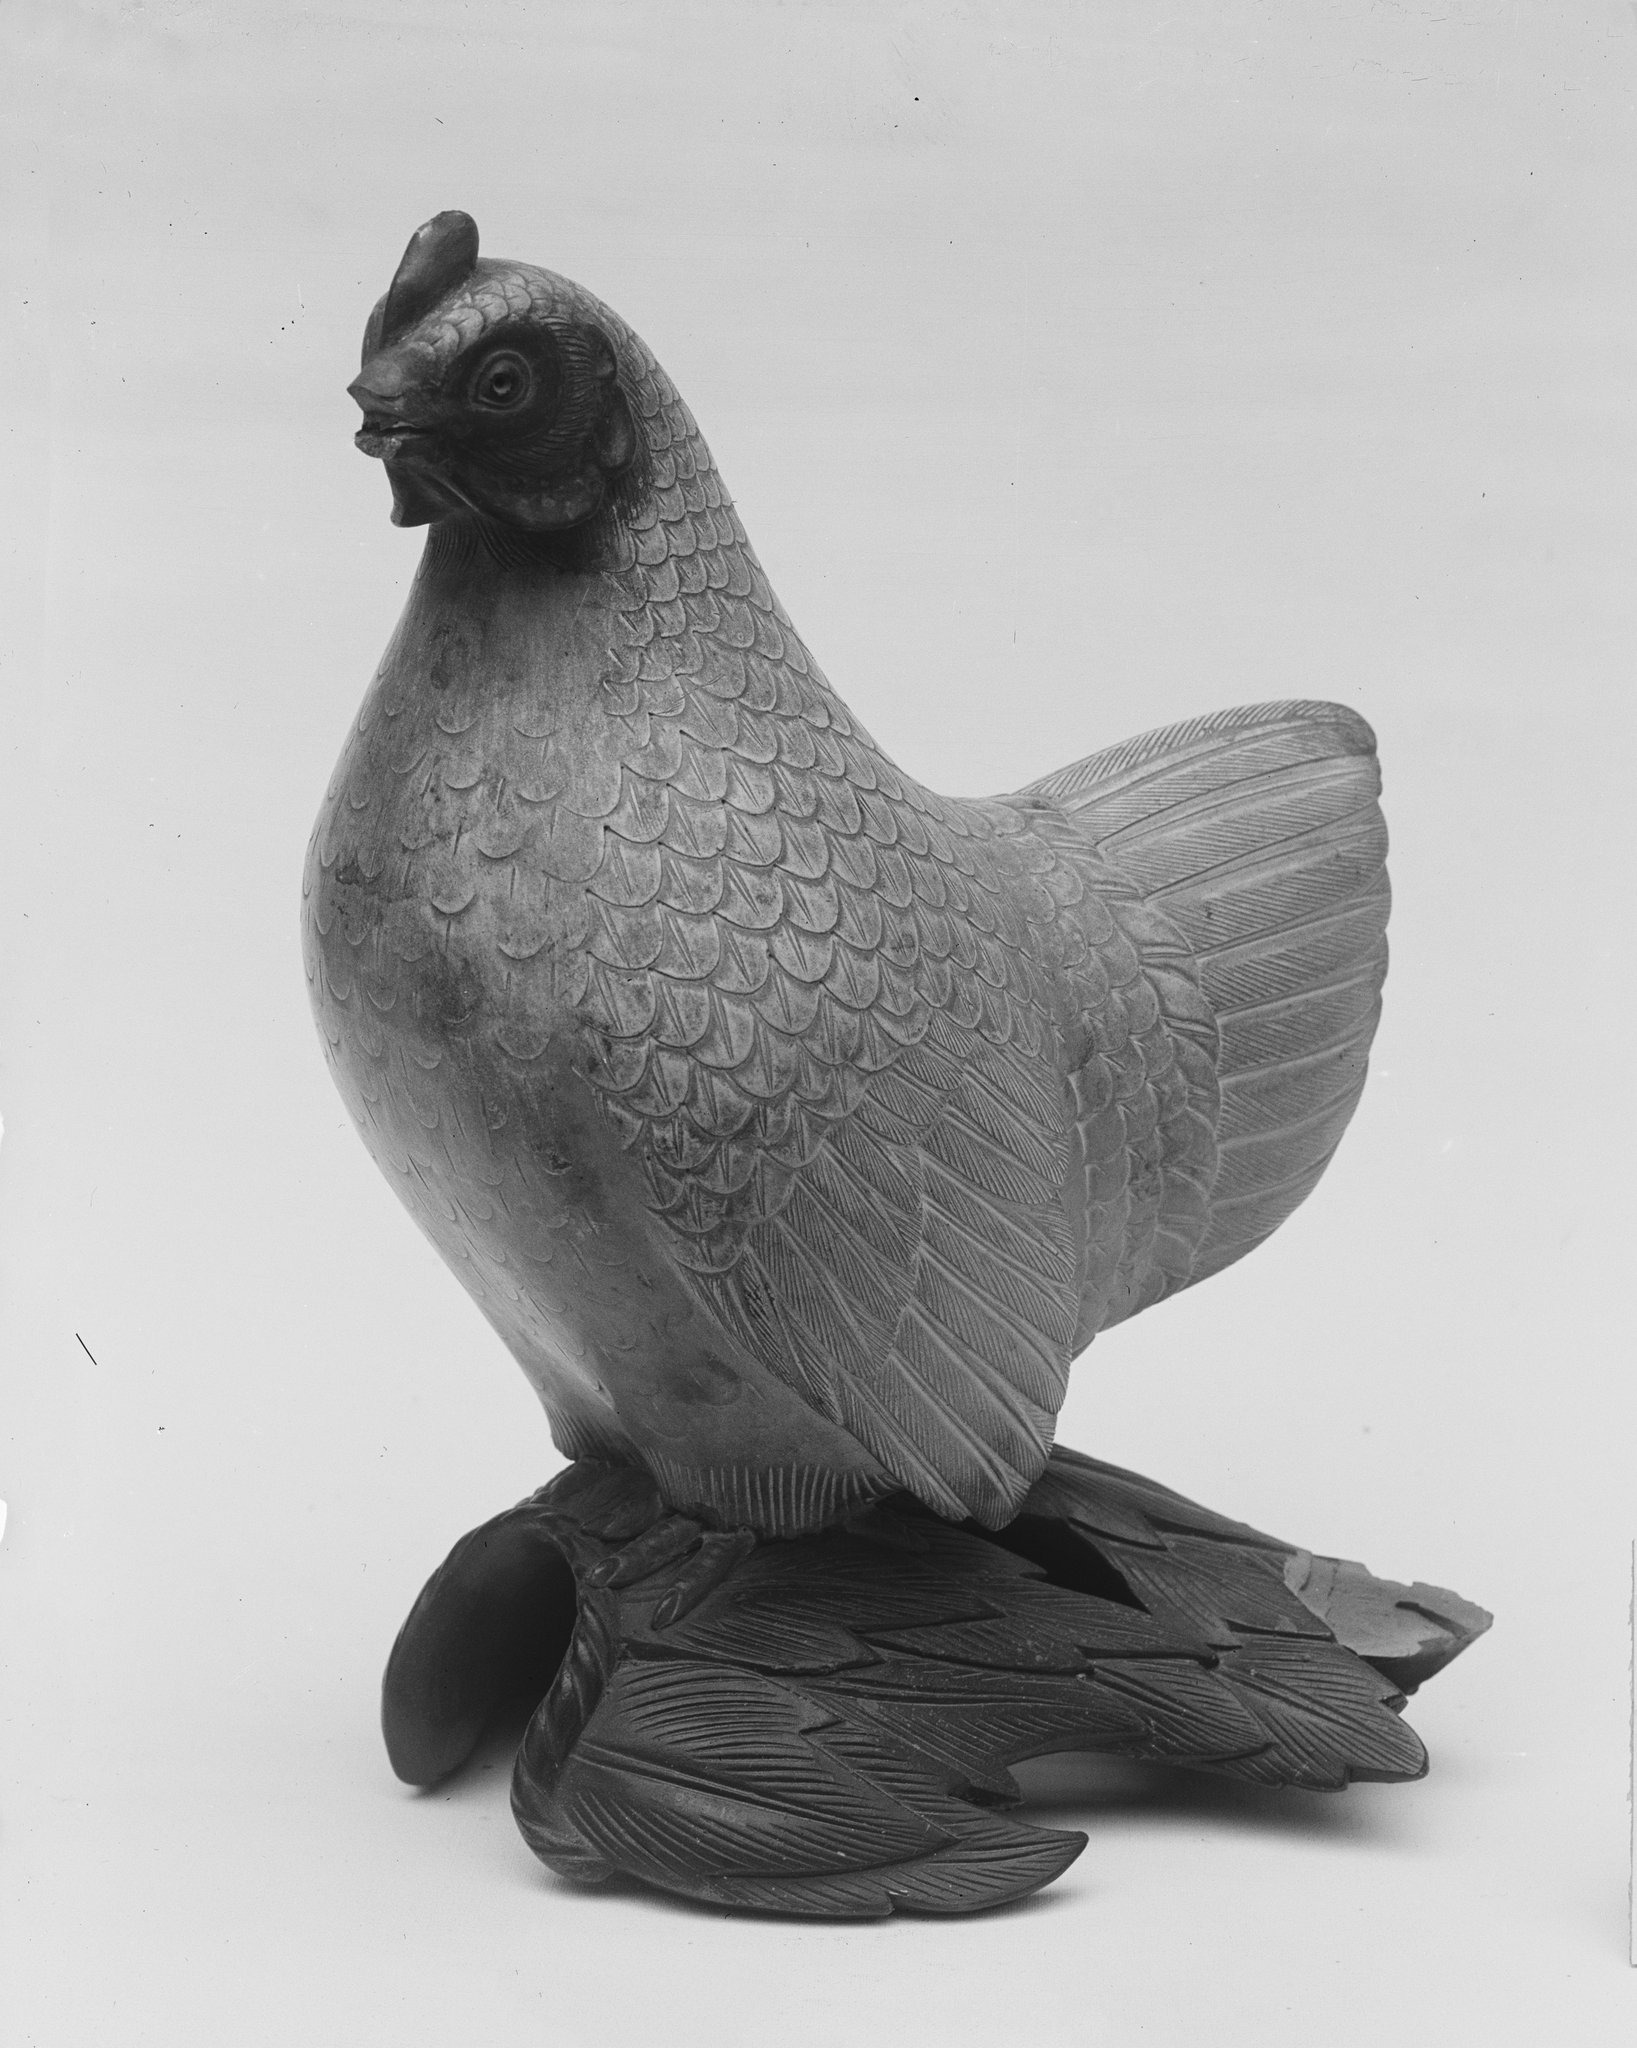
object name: ornament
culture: japanese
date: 1750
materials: clay, glaze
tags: chickens